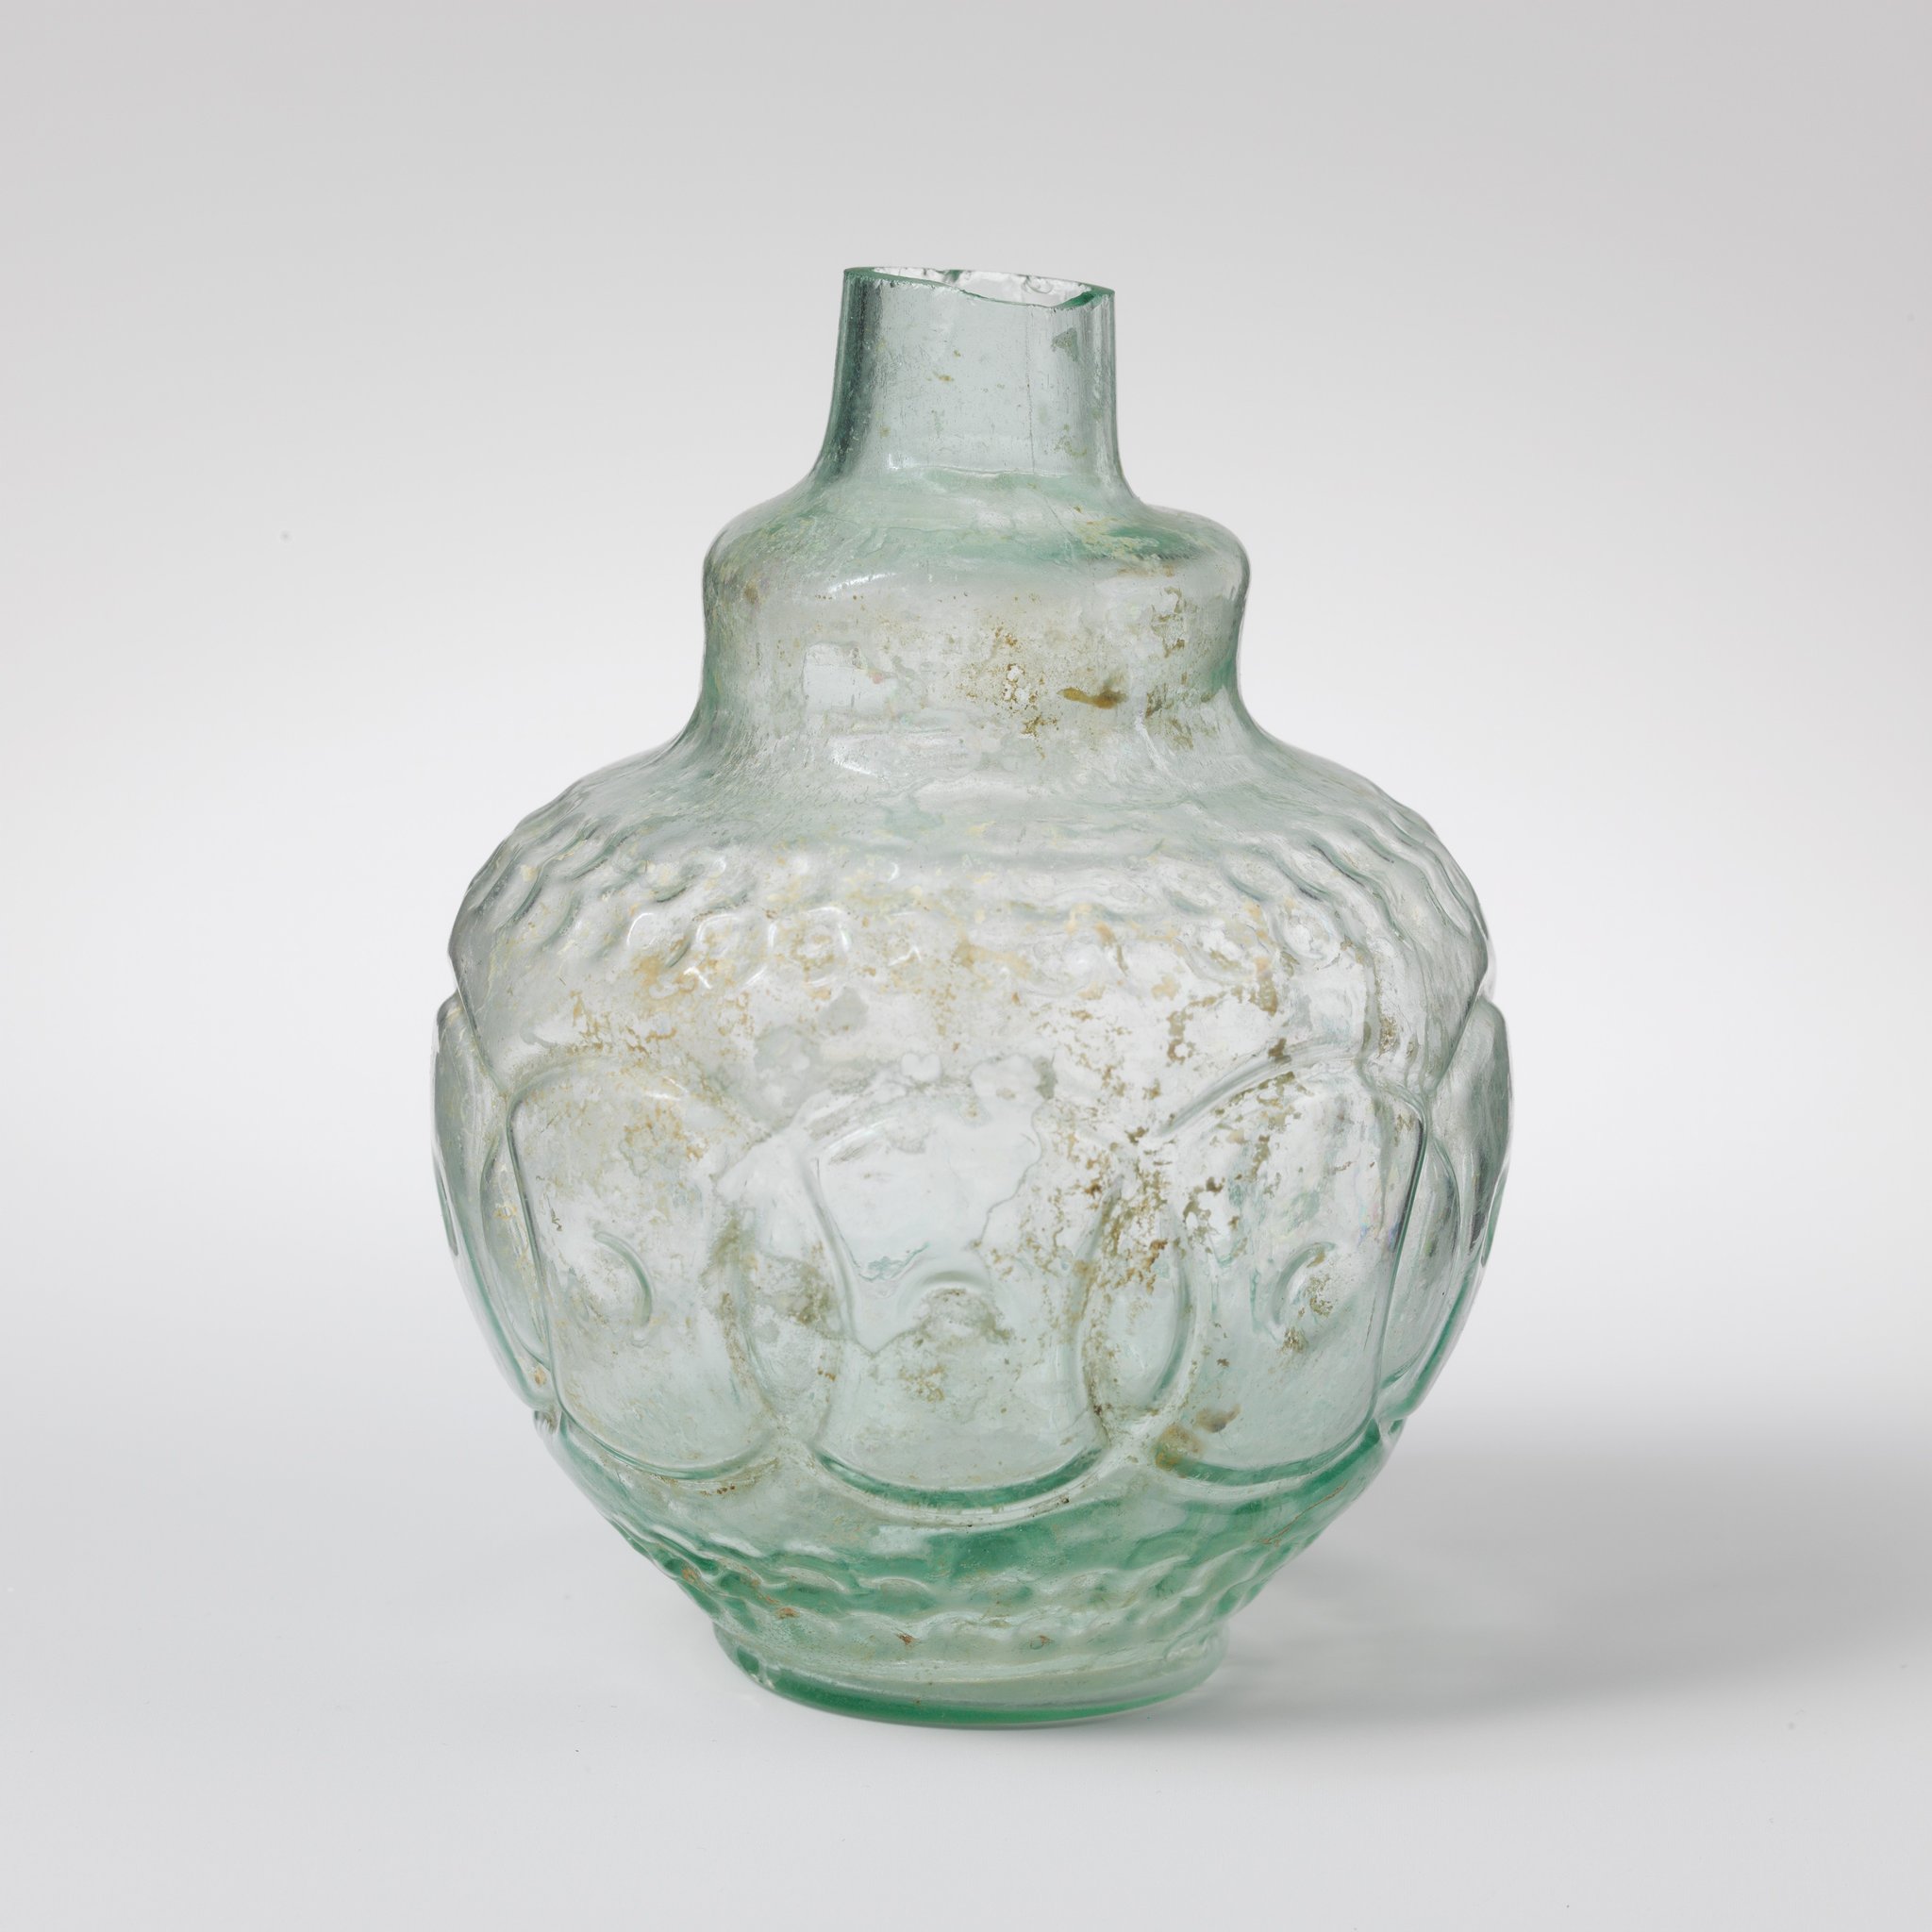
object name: flask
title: Glass flask decorated with intersecting circles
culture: roman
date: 101-300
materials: glass